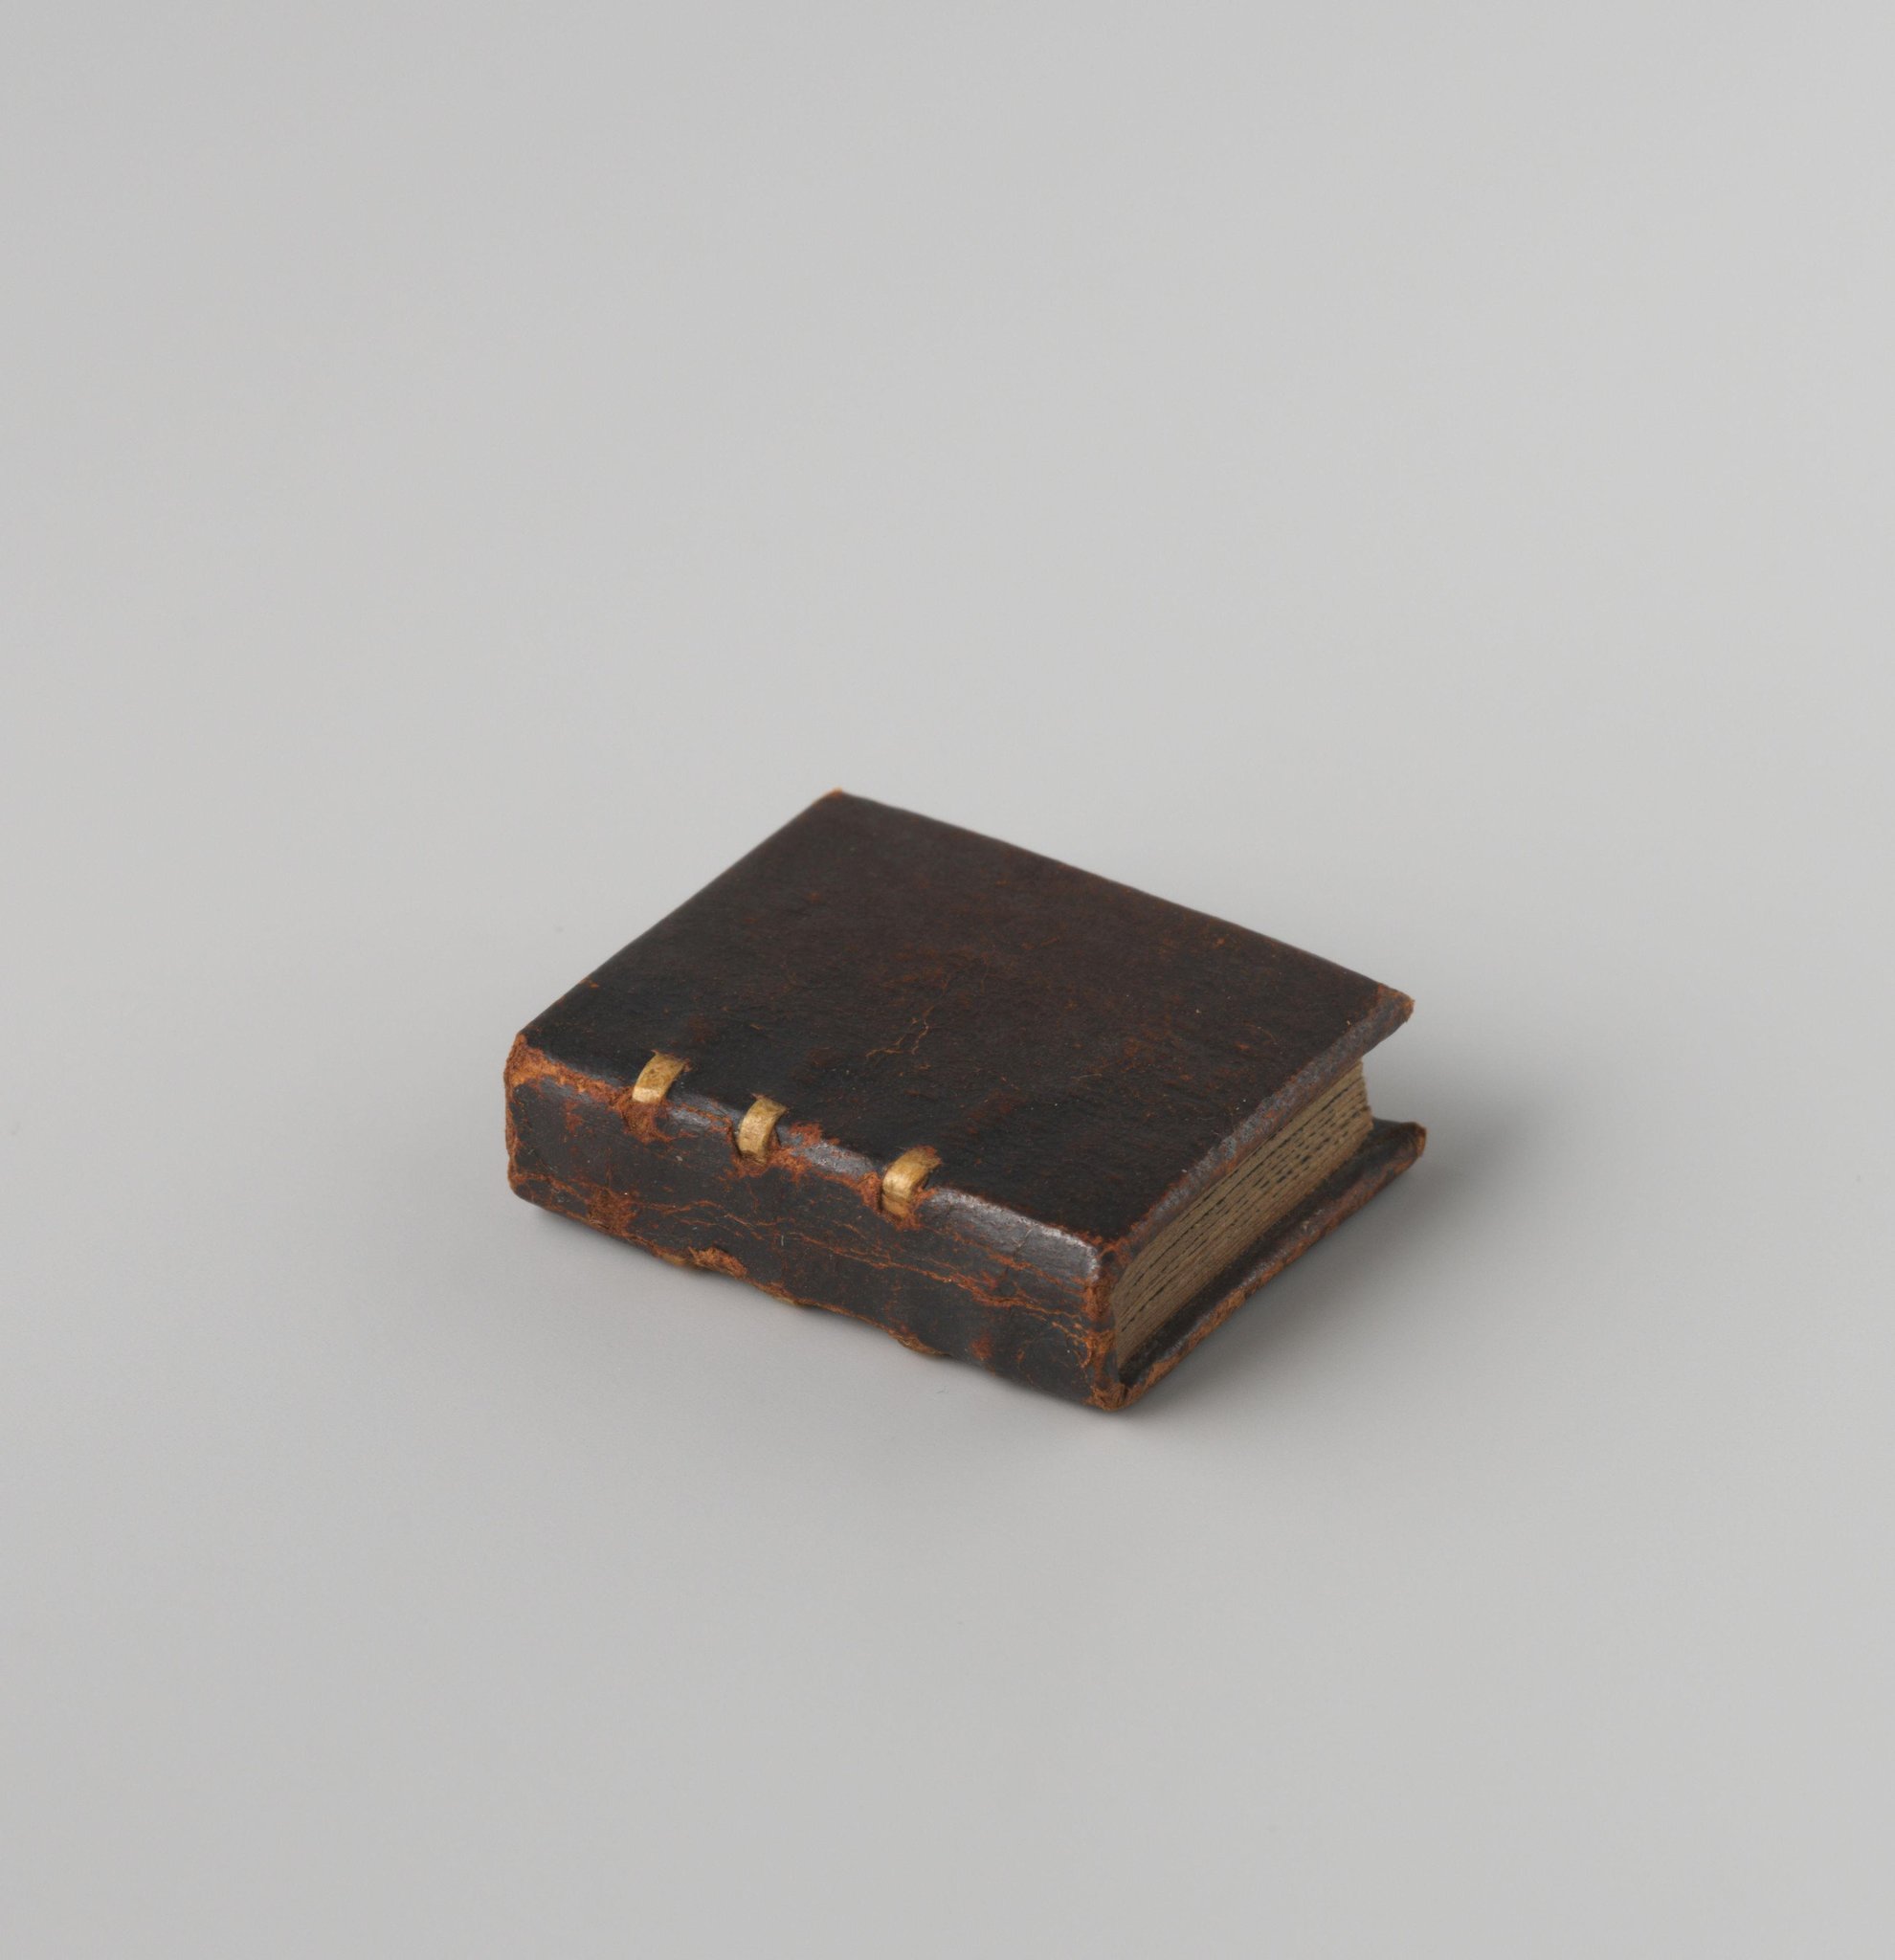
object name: book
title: Wapenboek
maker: Anonymous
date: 1690-1710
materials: leather, paper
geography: amsterdam